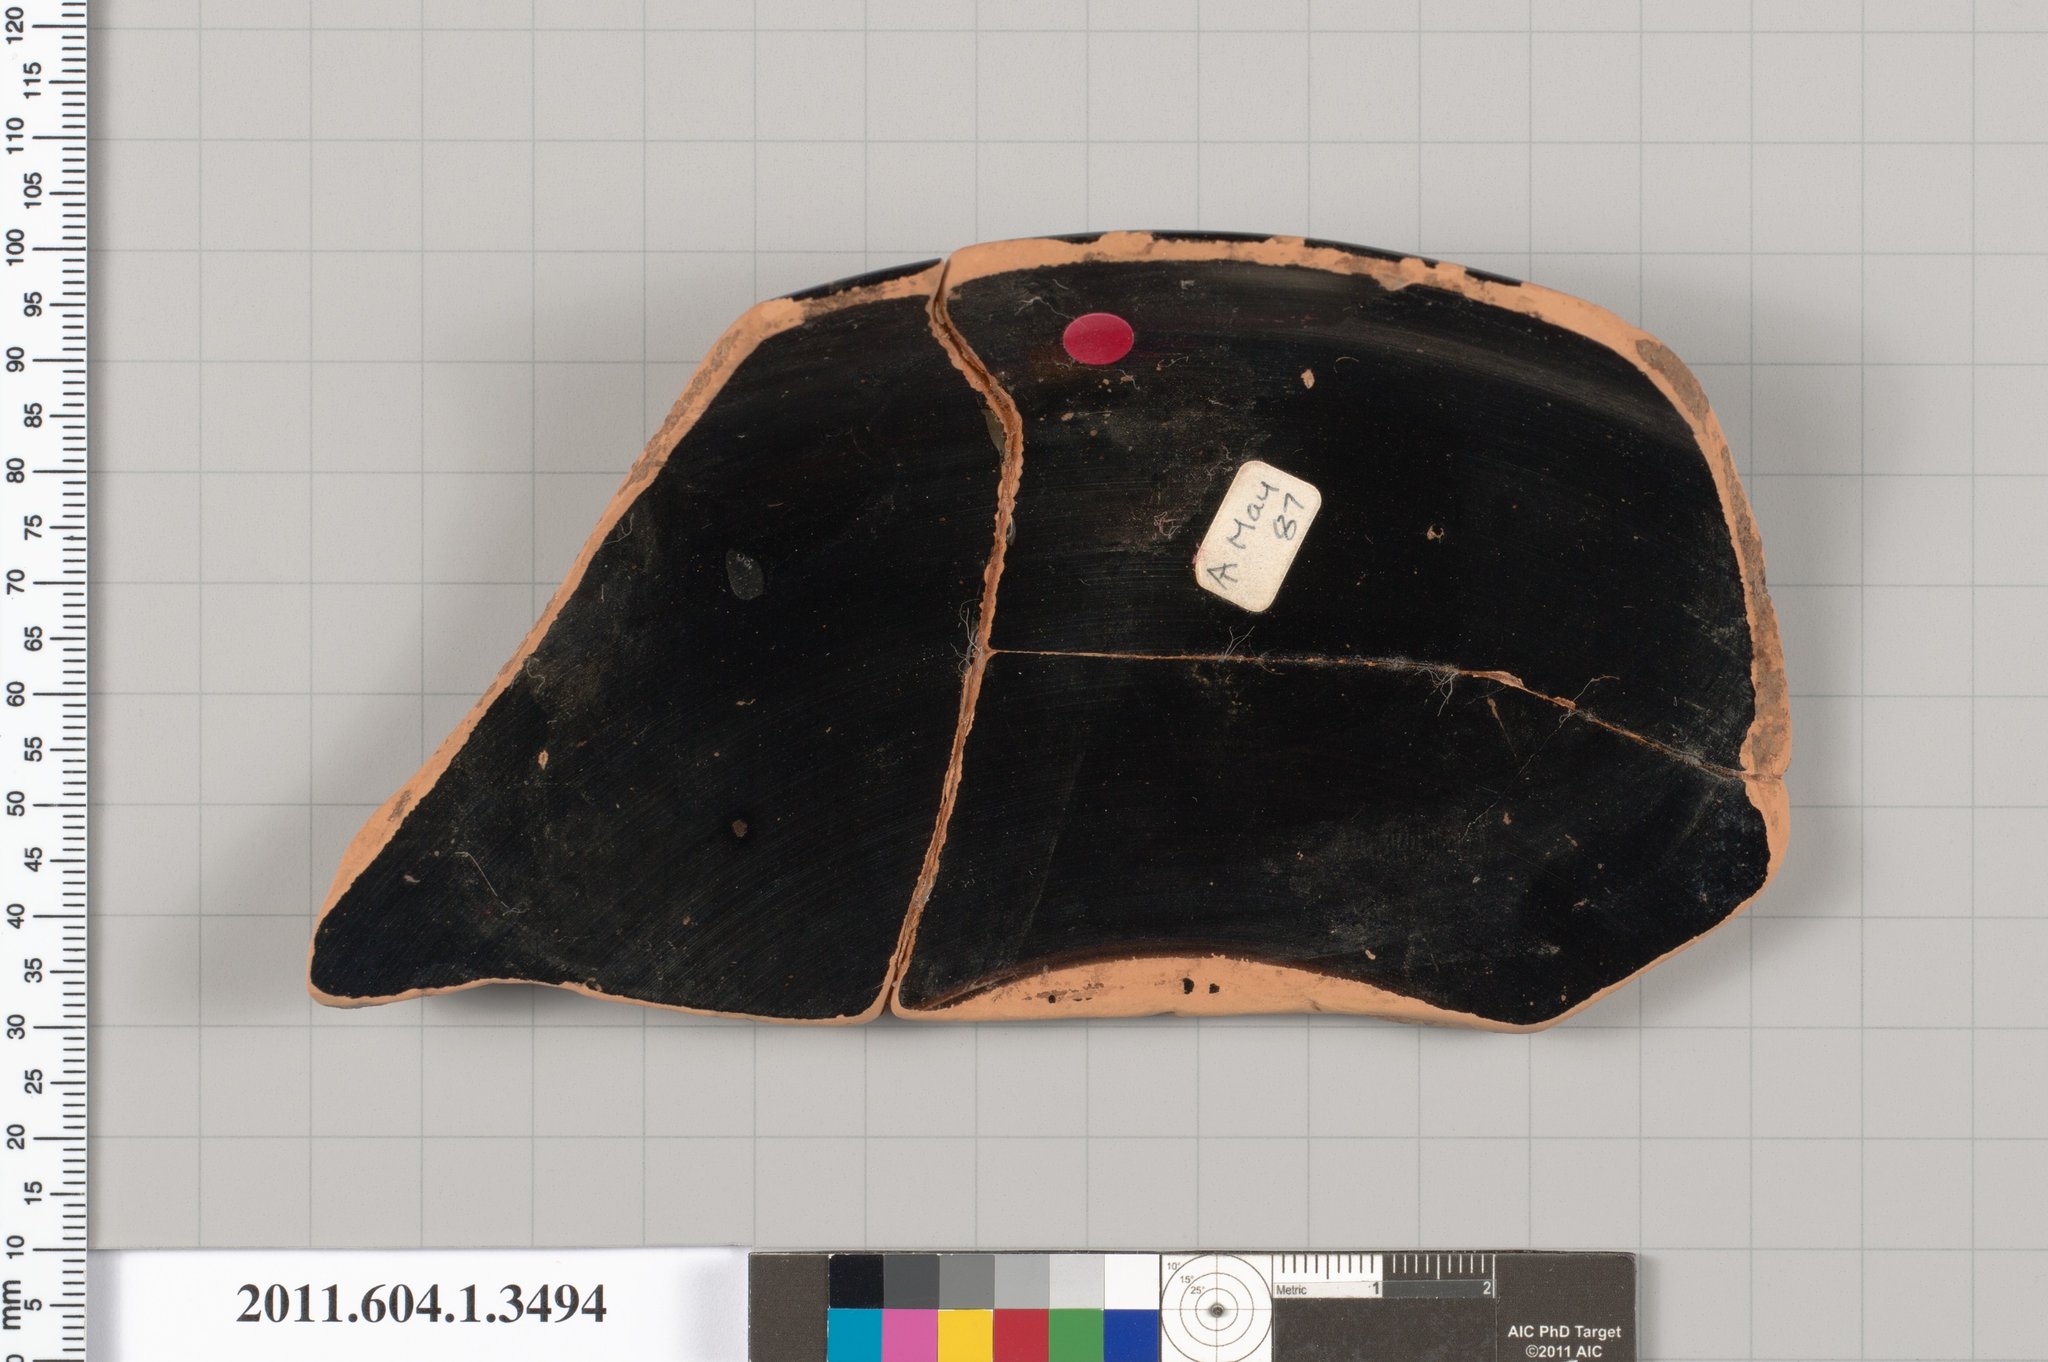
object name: kylix fragment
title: Terracotta fragment of a kylix (drinking cup)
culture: greek, attic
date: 467-435 BCE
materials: terracotta